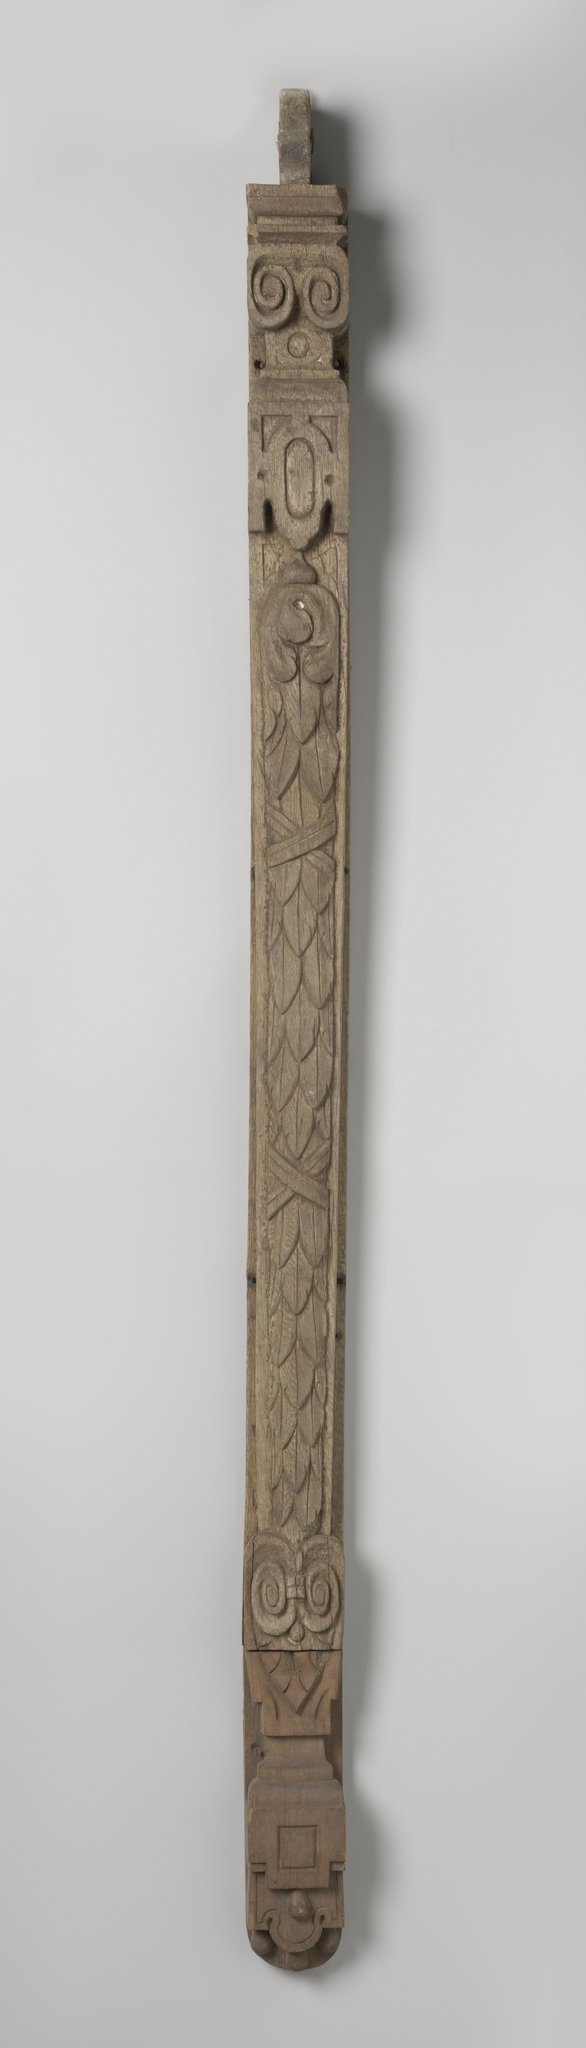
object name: stile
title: Gebeeldhouwde stijl van eikenhout, afkomstig uit het z.g. Huis van Alva, Warmoestraat te Amsterdam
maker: Anonymous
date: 1500-1699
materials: wood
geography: northern netherlands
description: Gebeeldhouwde eikenhouten stijl zonder afwerking, afkomstig uit het z.g. Huis van Alva, Warmoestraat te Amsterdam. In totaal gaat het om twee consoles, drie brede en drie smalle stijlen (BK-KOG-755-A t/m D, F t/m H). Zie tevens BK-KOG-754-1 t/m 7, dit zijn 6 beschilderde stijlen die uit hetzelfde huis afkomstig zijn.